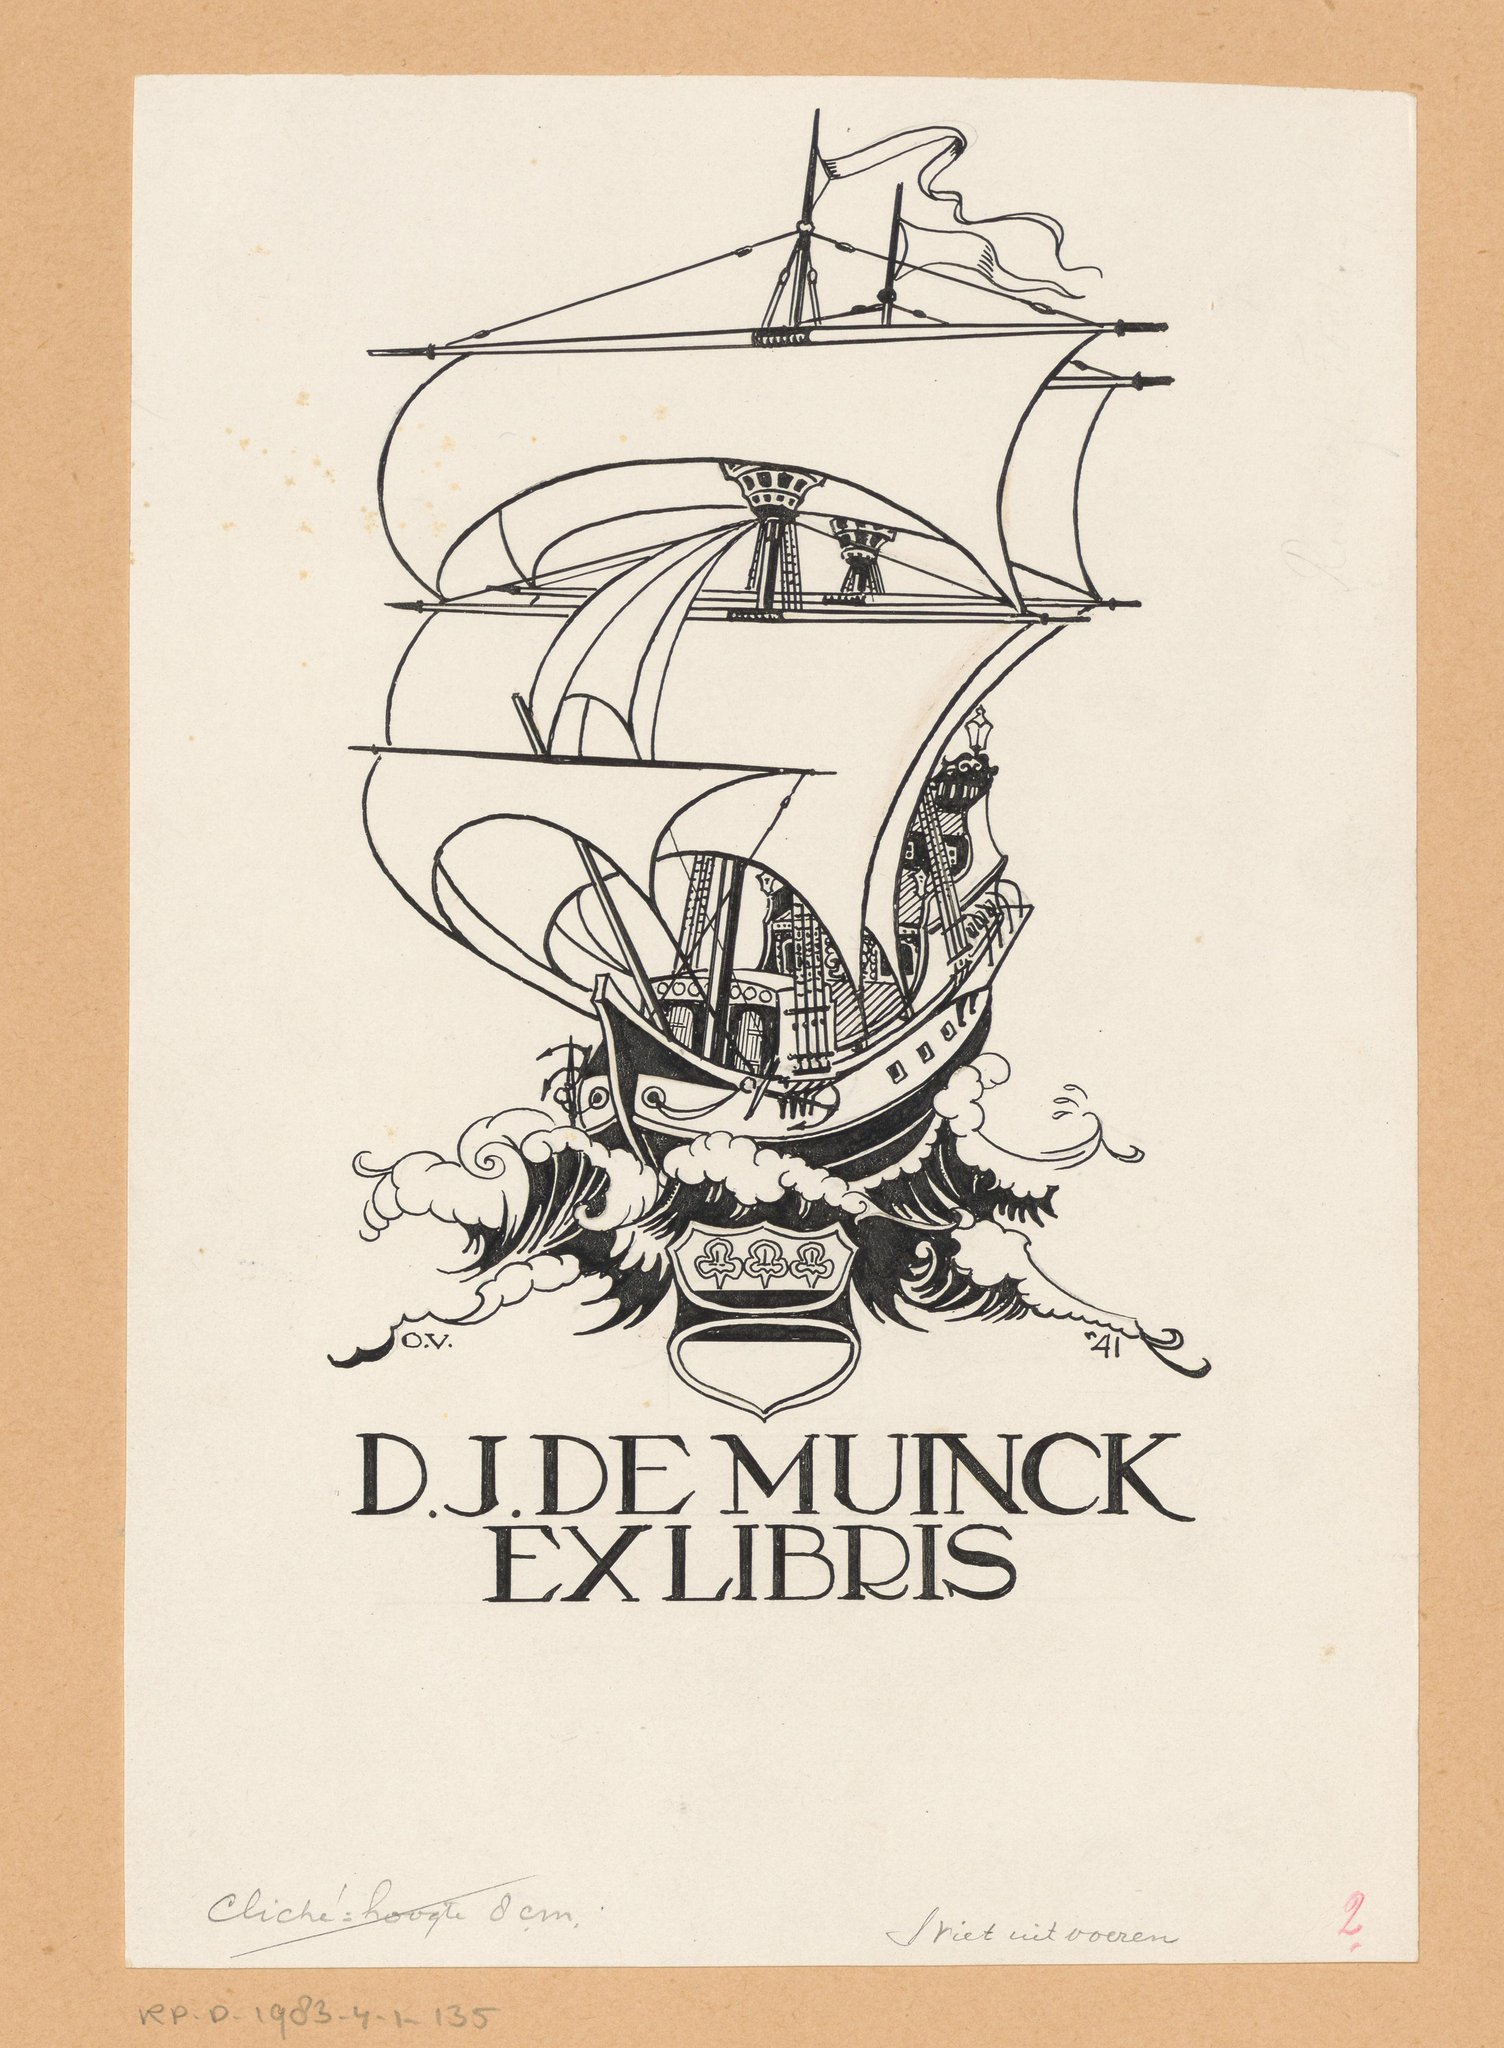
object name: bookplate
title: Ex libris van D.J. de Muinck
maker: otto verhagen (i)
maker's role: draughtsman, print maker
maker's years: 1885-1951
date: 1941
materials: ink, paper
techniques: drawing, pen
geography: netherlands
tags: manufacturer, sailing-ship, sailing-boat, armorial bearing, heraldry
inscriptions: inscription: ‘Niet uitgevoerd ontwerp (verg. no. 55)’, inscription: ‘Cliché = hoogte 8 cm/ Niet uitvoeren’